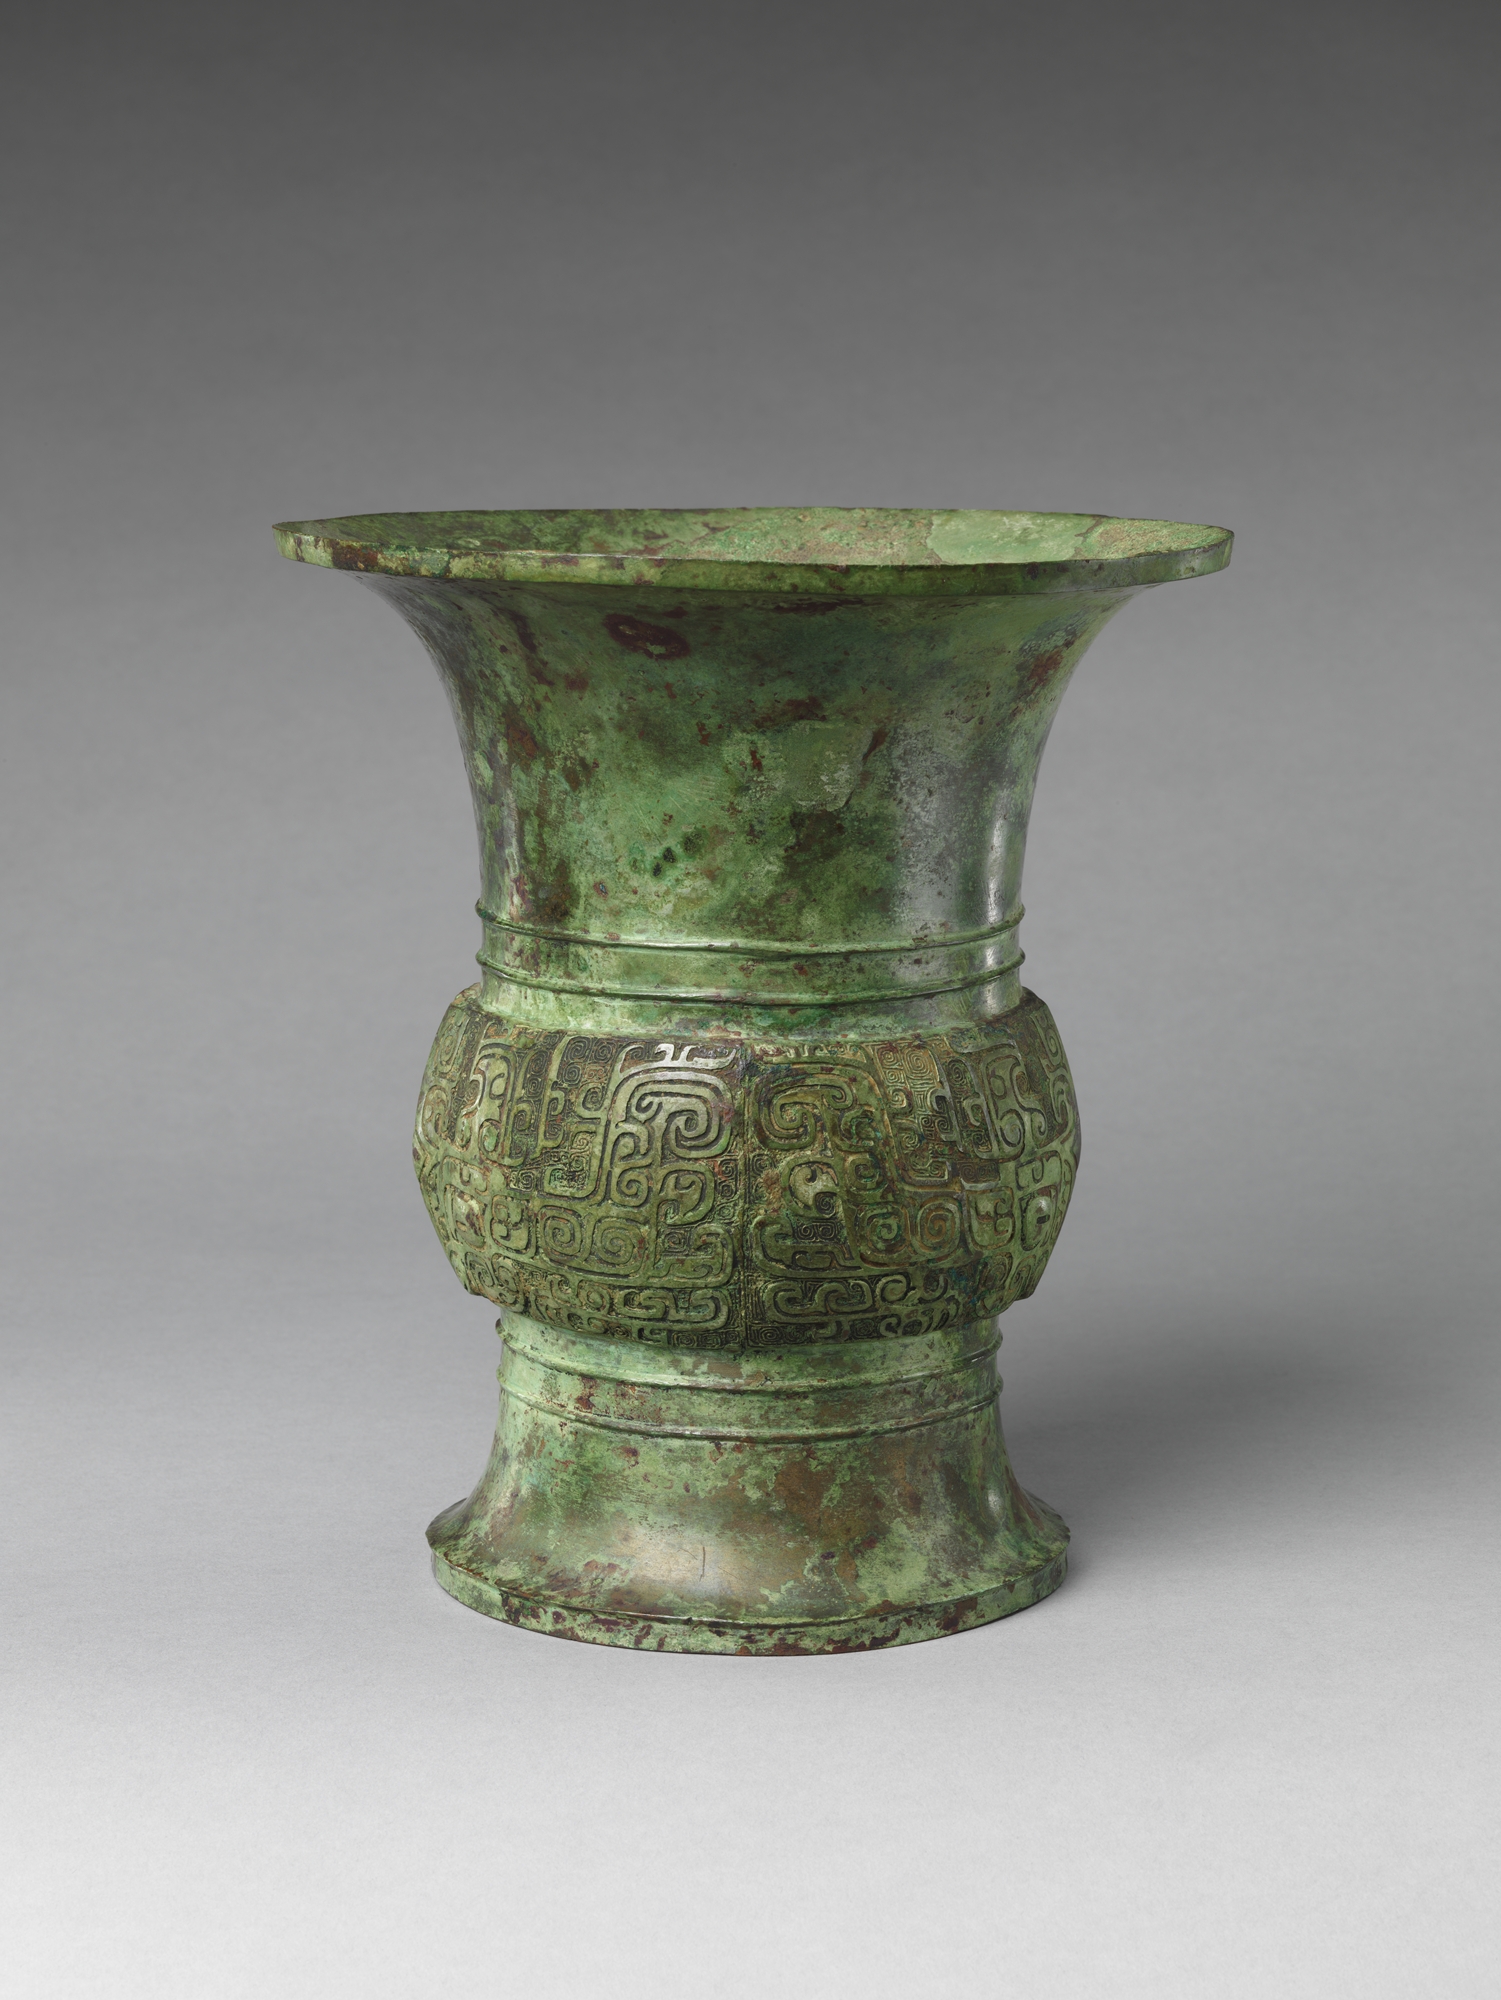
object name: wine container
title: Wine container (zun)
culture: chinese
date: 1300-1201 BCE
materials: bronze